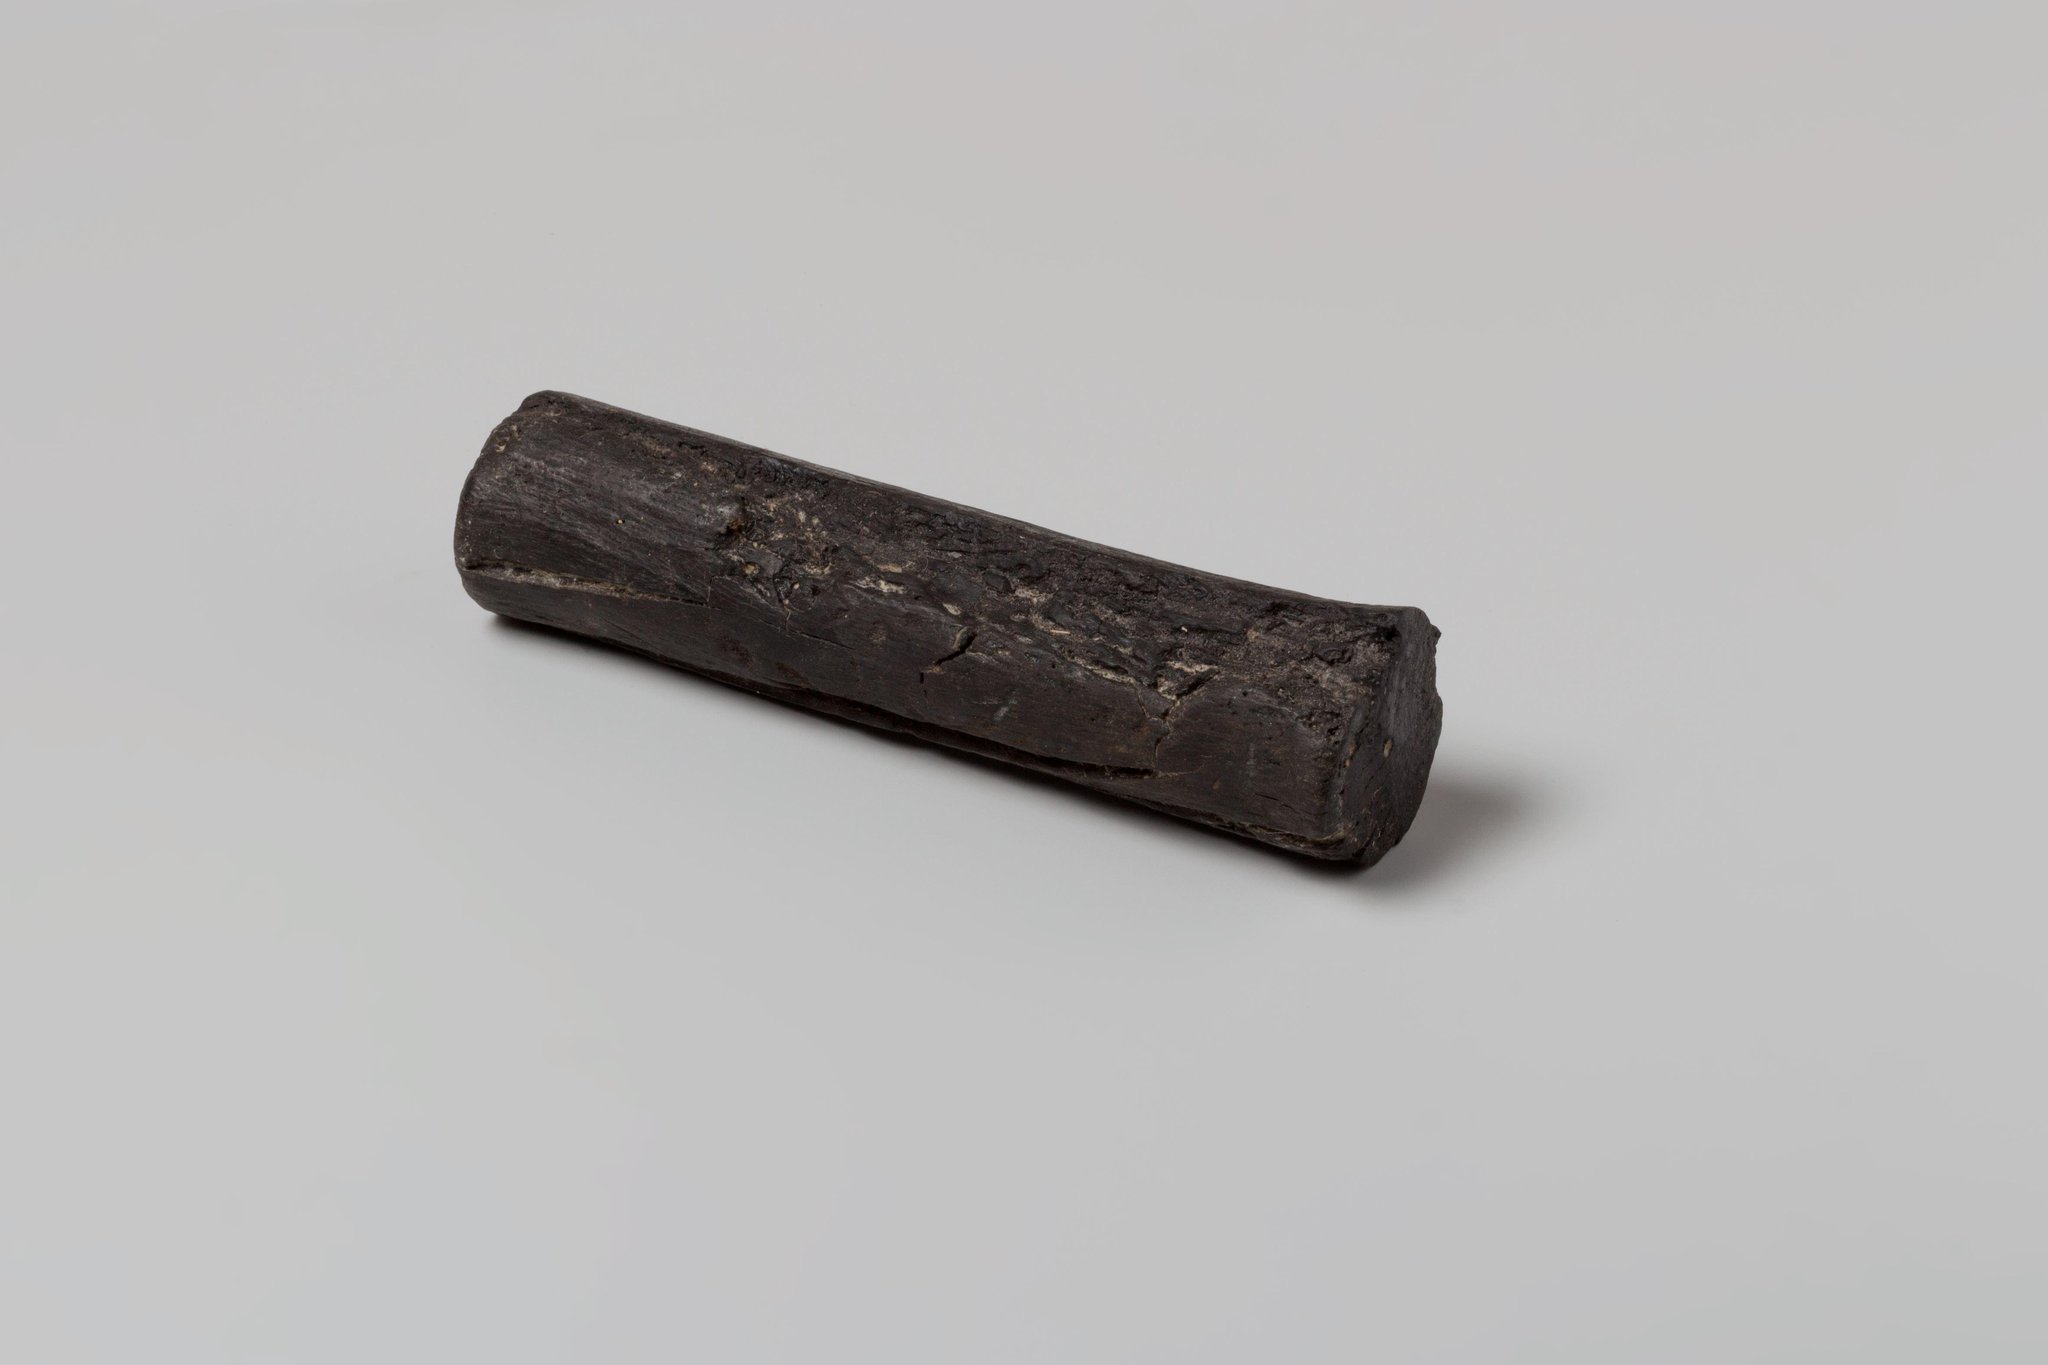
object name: nagelas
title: Nagelas uit V.O.C.-schip de 'Witte Leeuw'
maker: Anonymous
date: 1613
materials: wood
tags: verenigde oostindische compagnie, sint-helena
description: Houten nagelas. Hout verweerd en gebarsten.